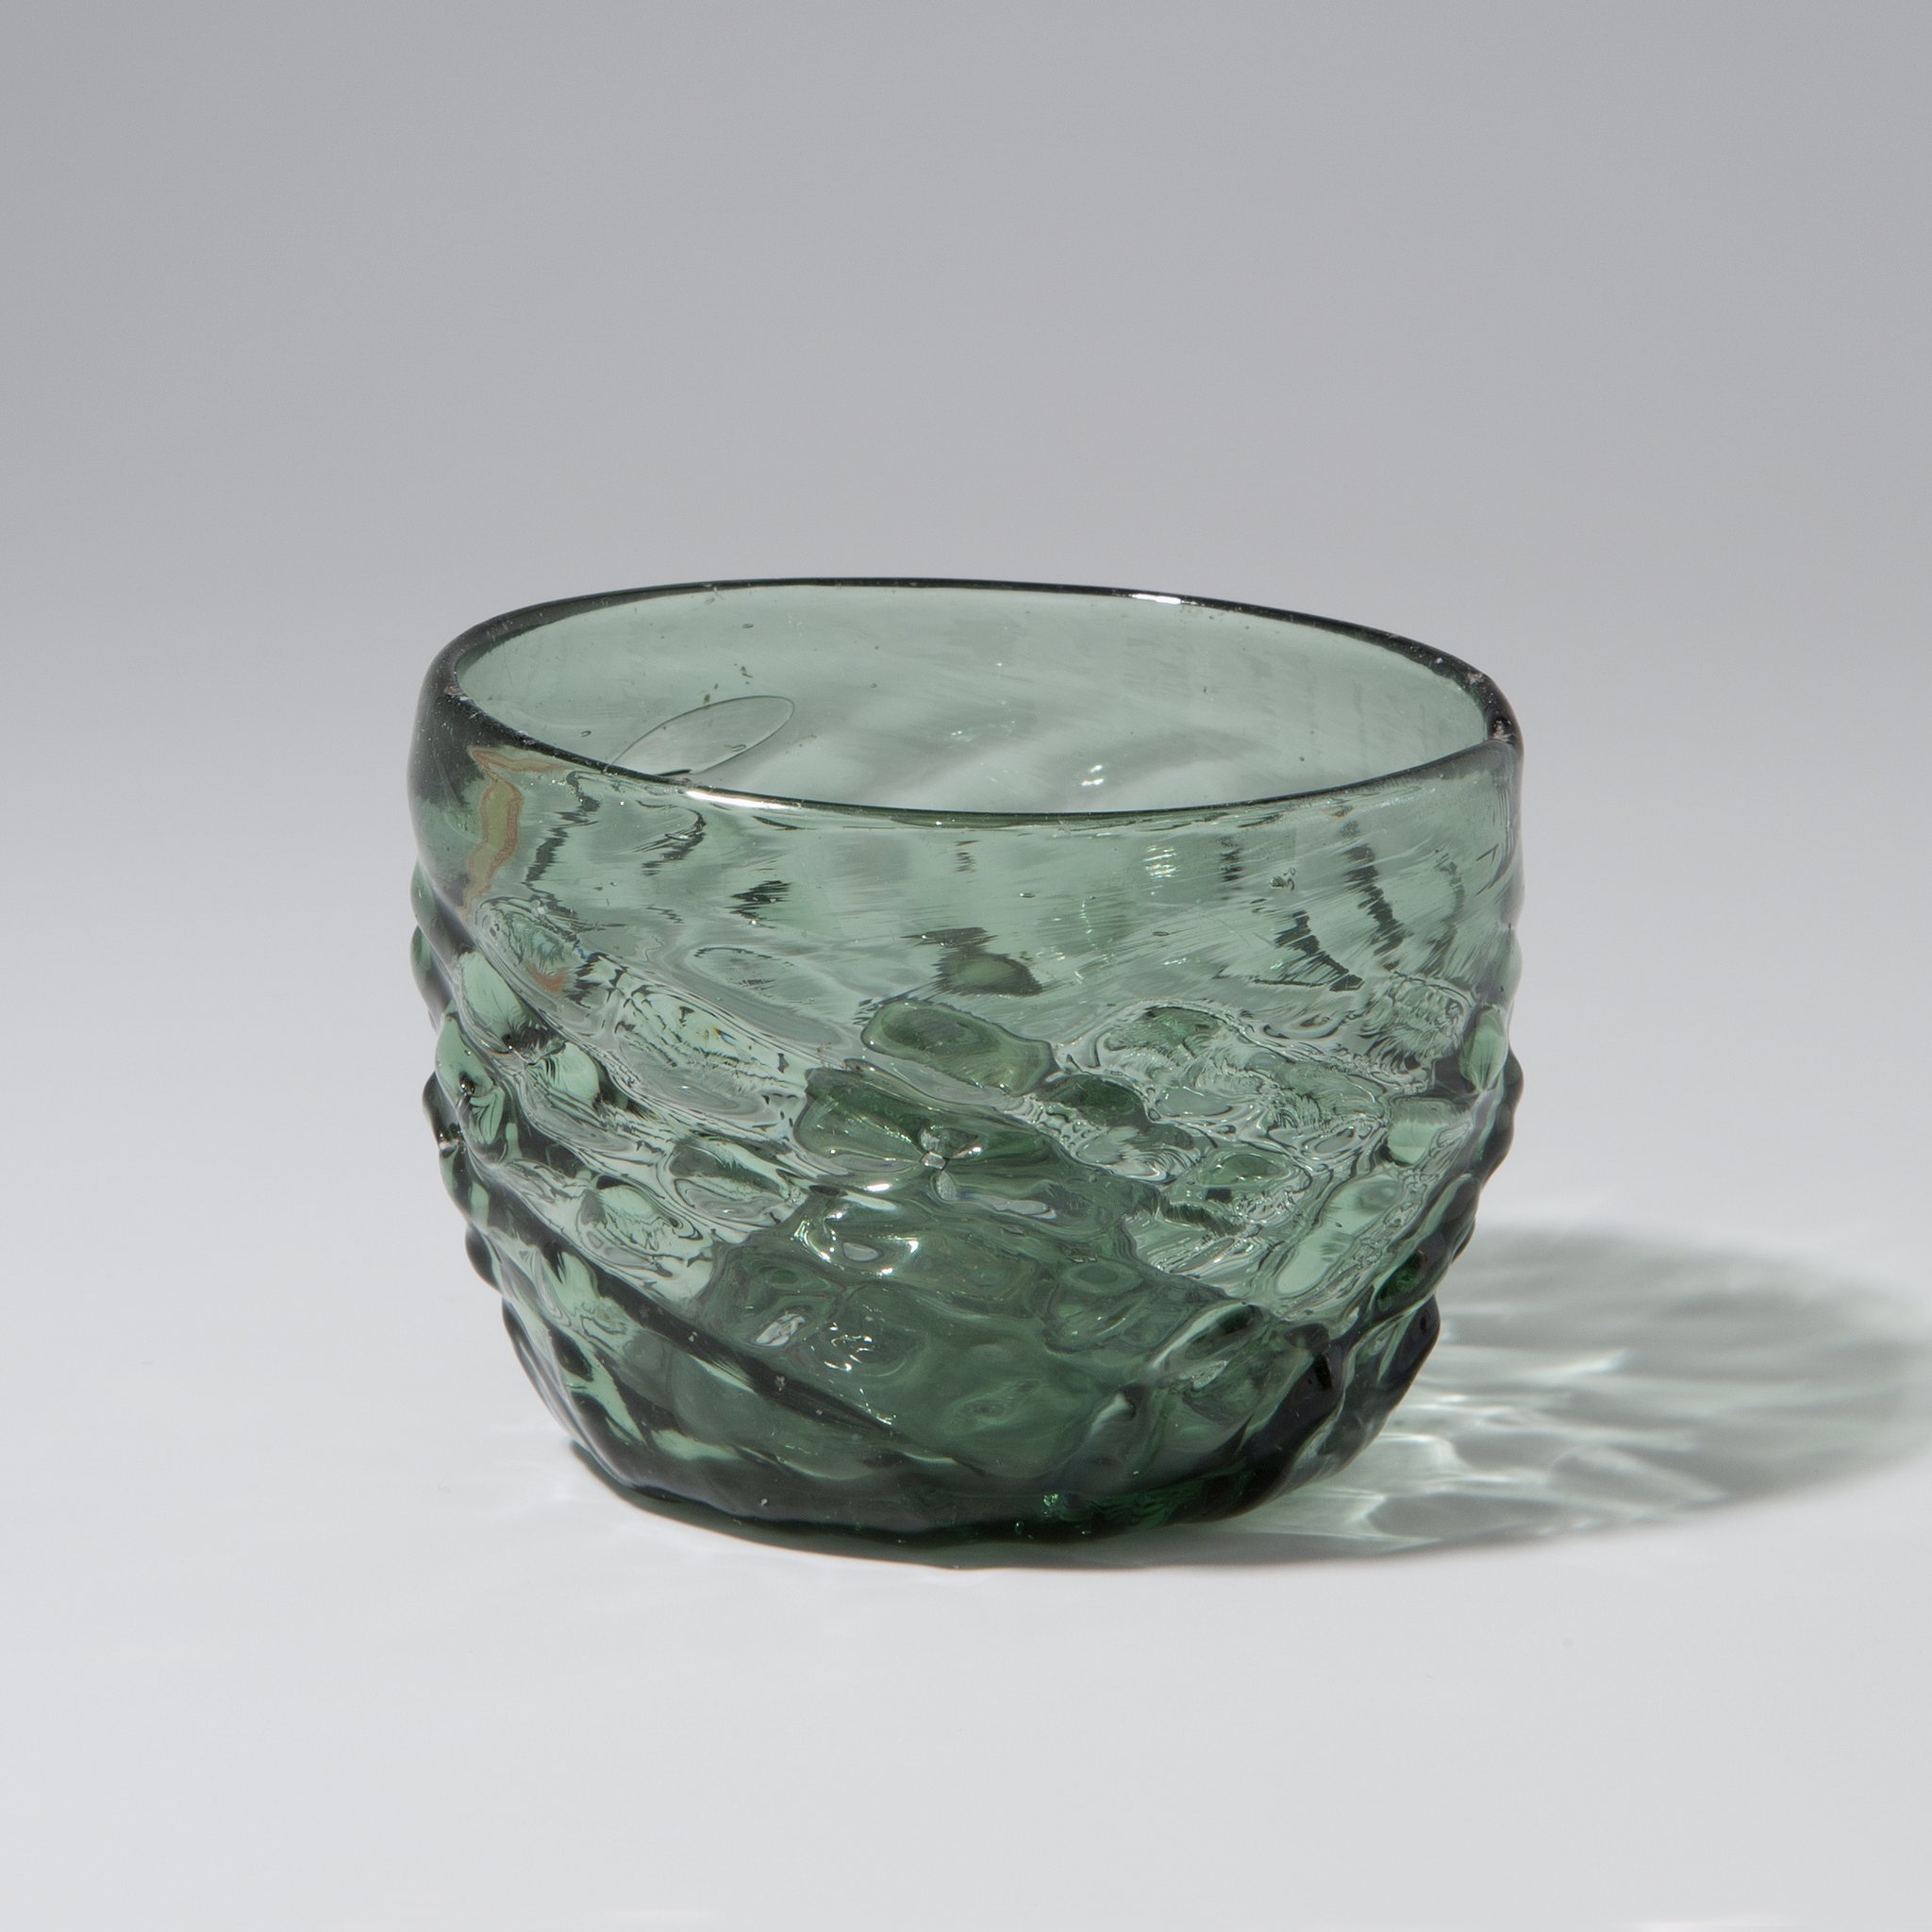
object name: beaker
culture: german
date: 1467-1500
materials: glass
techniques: glassblowing